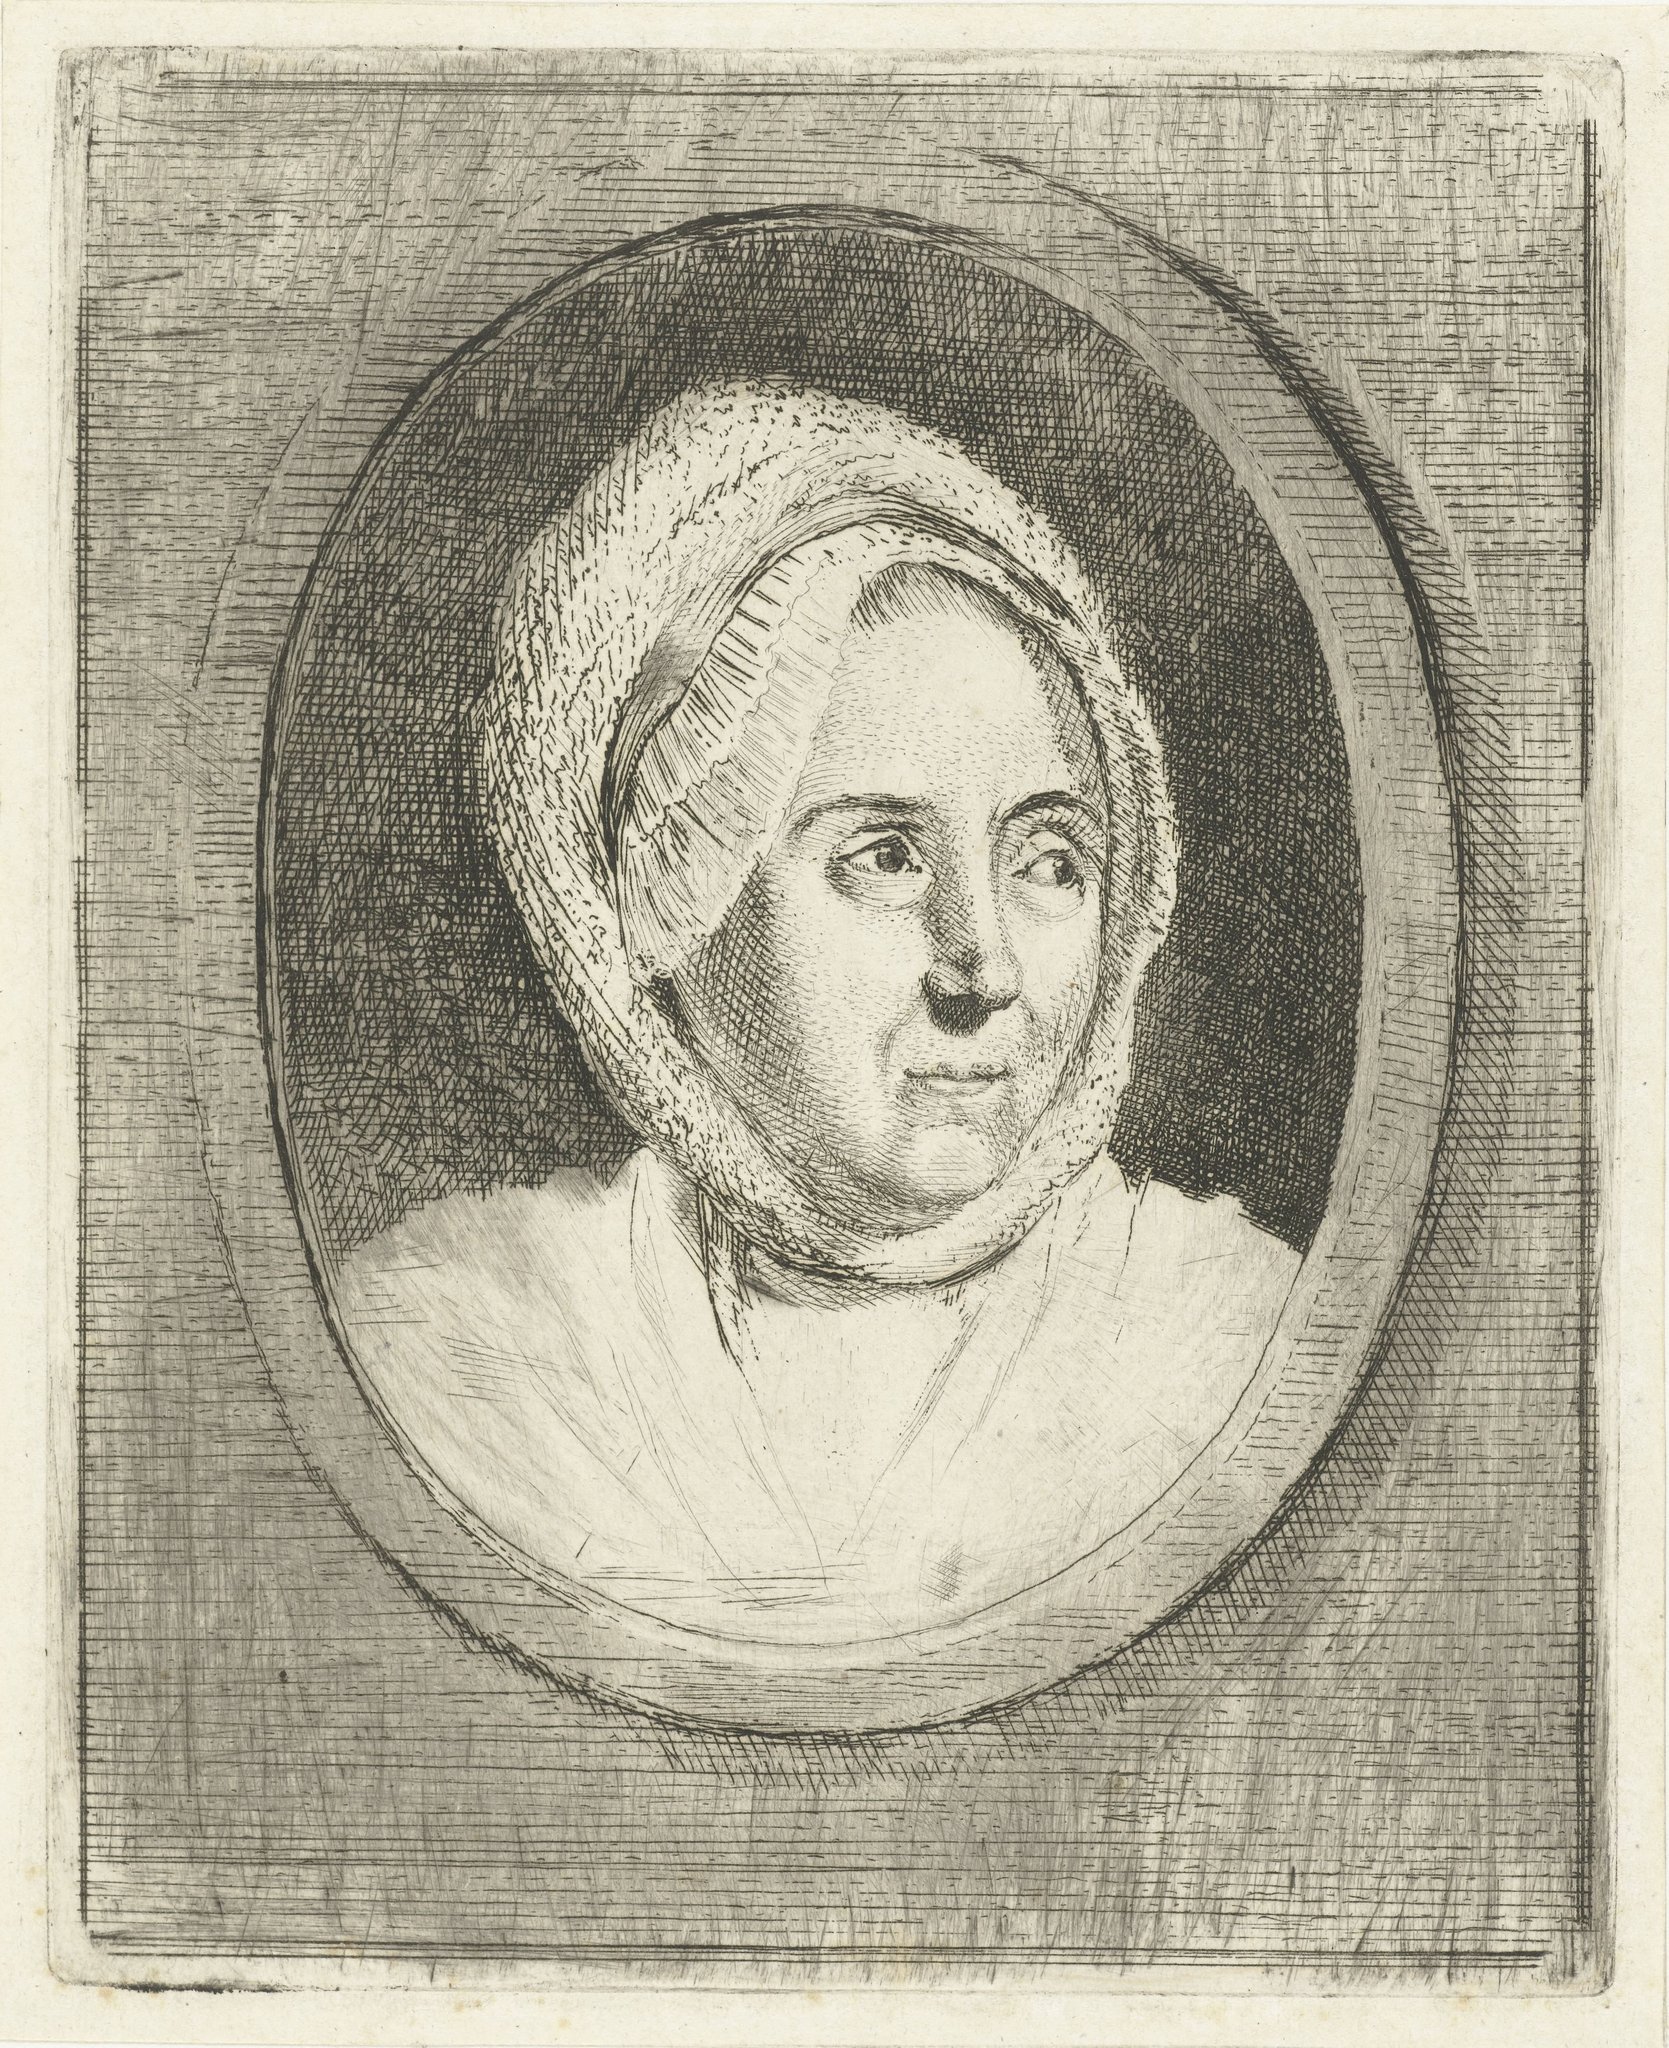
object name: print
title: Portret van een vrouw met kapje (Marie Joseph Bertrand?)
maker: louis bernard coclers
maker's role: draughtsman, print maker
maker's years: 1741-1817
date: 1756-1817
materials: paper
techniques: etching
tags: anonymous historical person portrayed alone - bb - woman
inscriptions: collector's mark: Lugt 2228